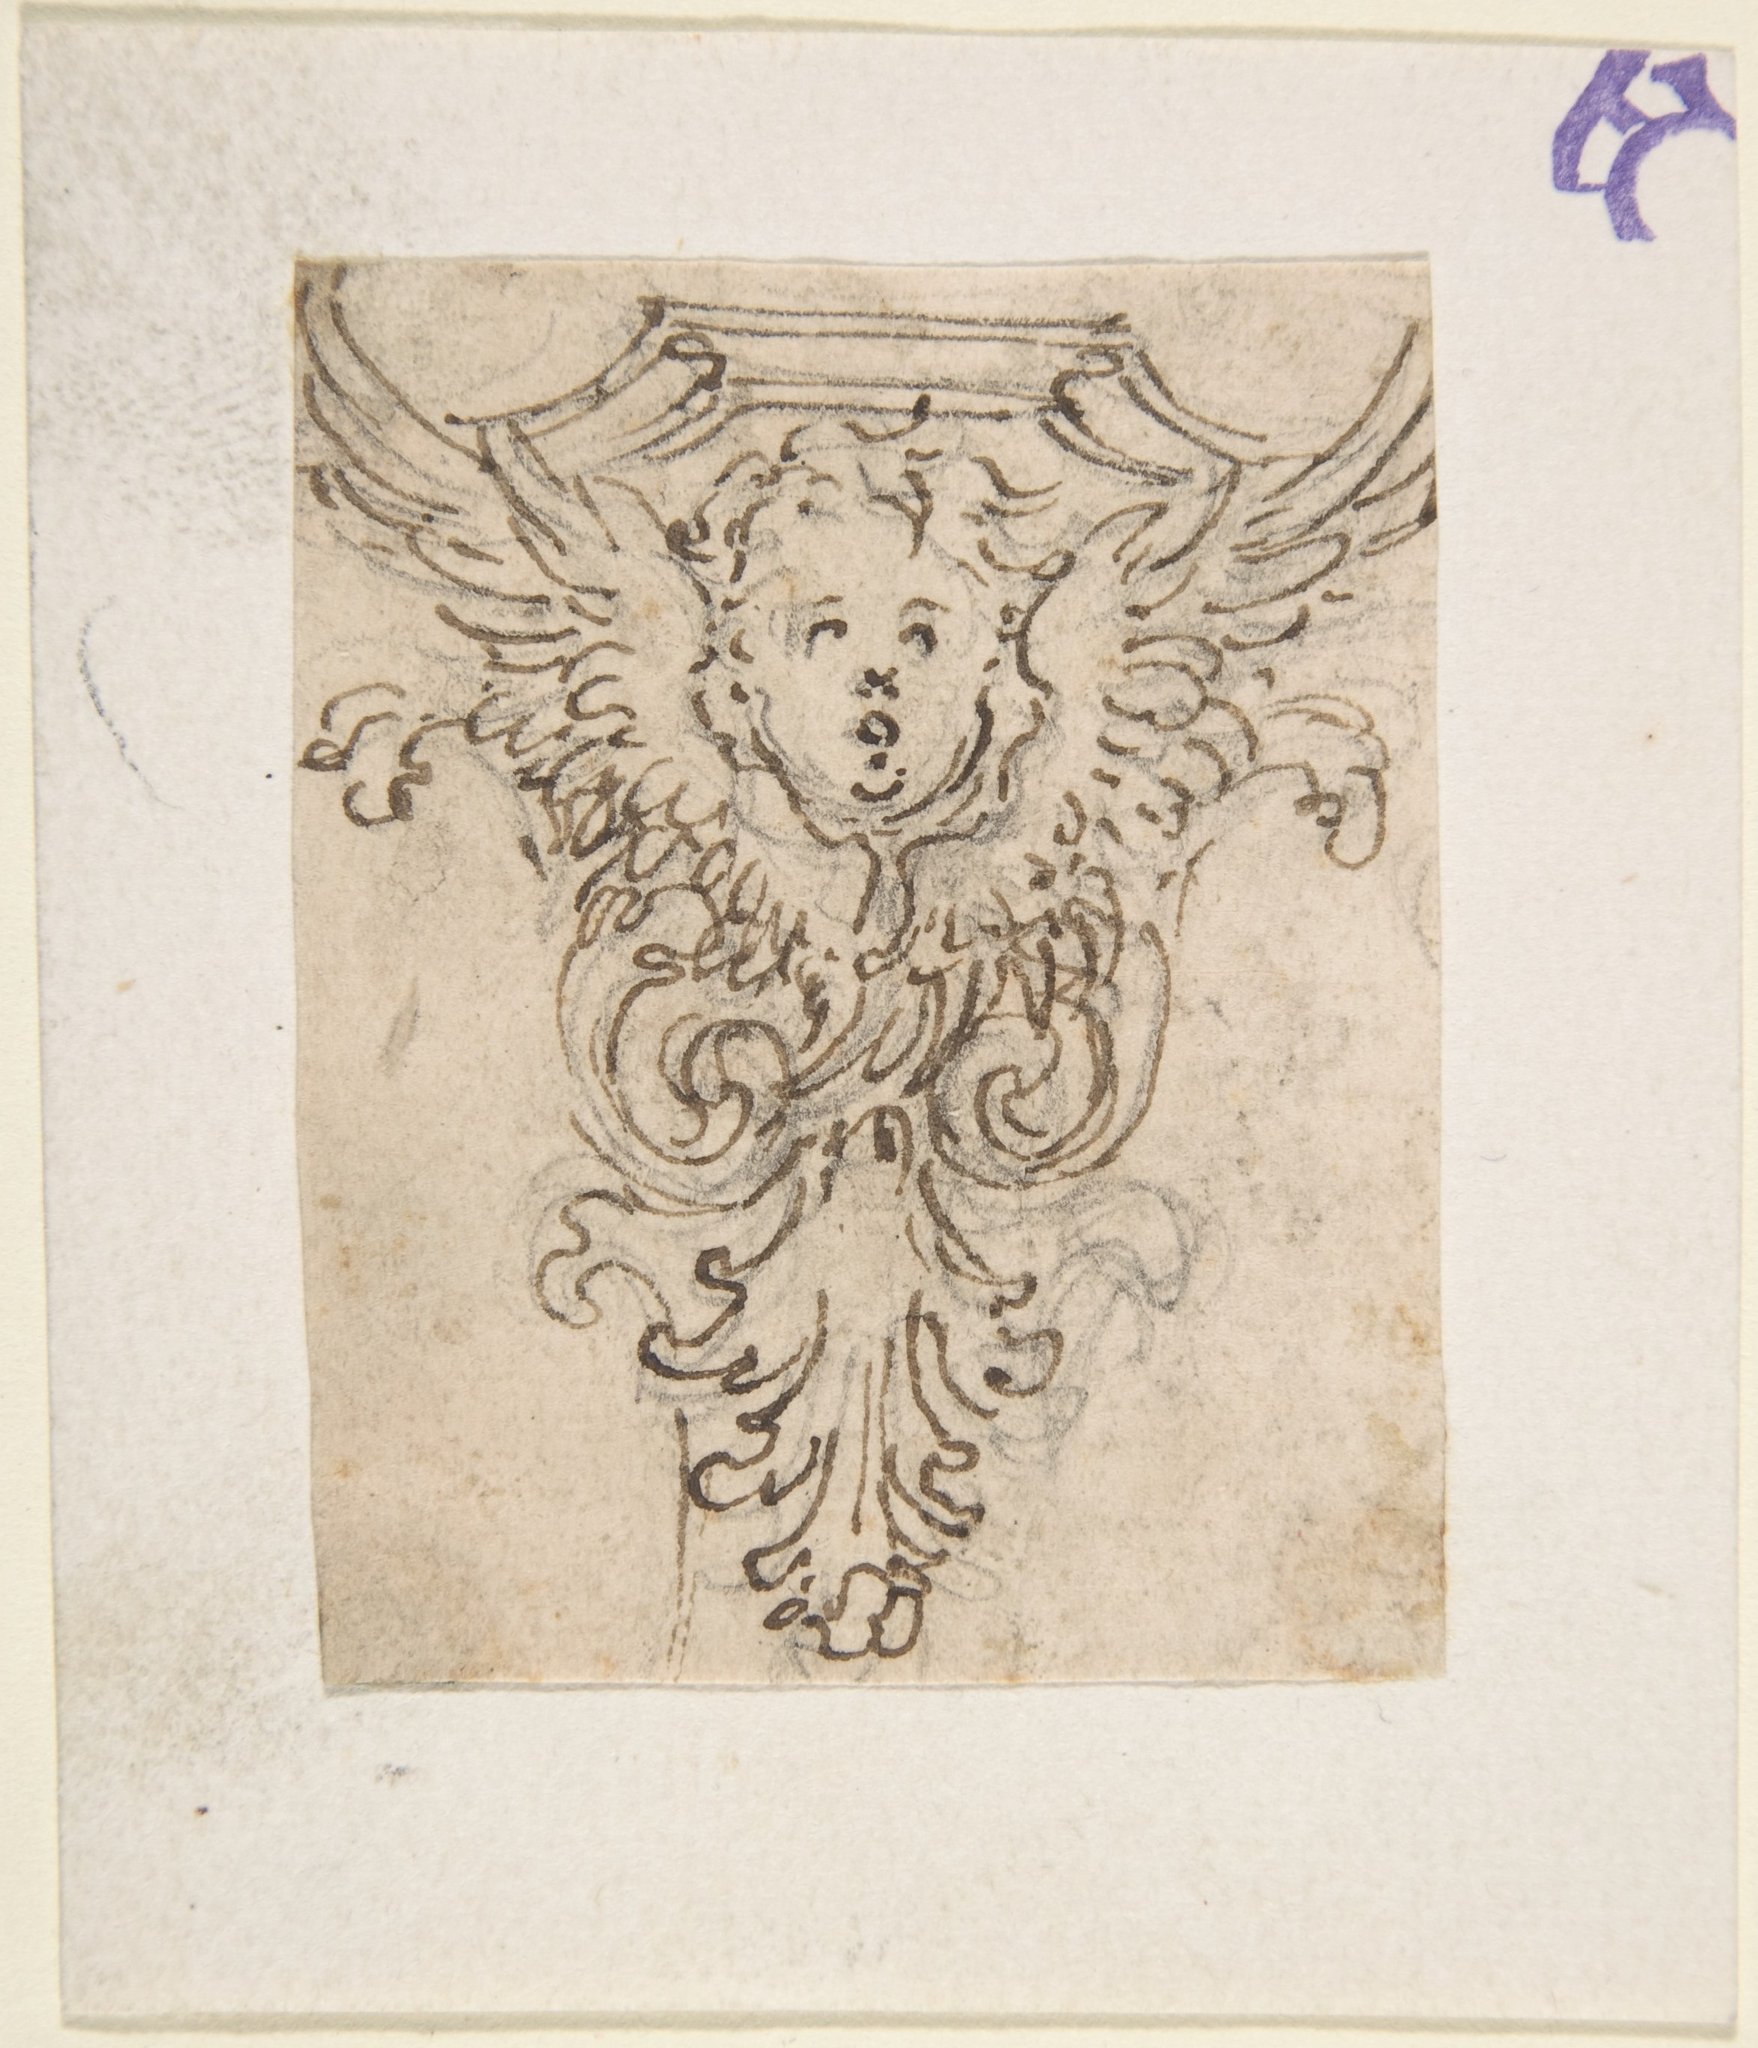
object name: drawing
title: Design for a Console or Capital with a Cherub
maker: giovanni battista foggini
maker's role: artist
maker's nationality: italian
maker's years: 1652-1725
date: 1672-1725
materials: chalk, ink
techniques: pen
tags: ornament